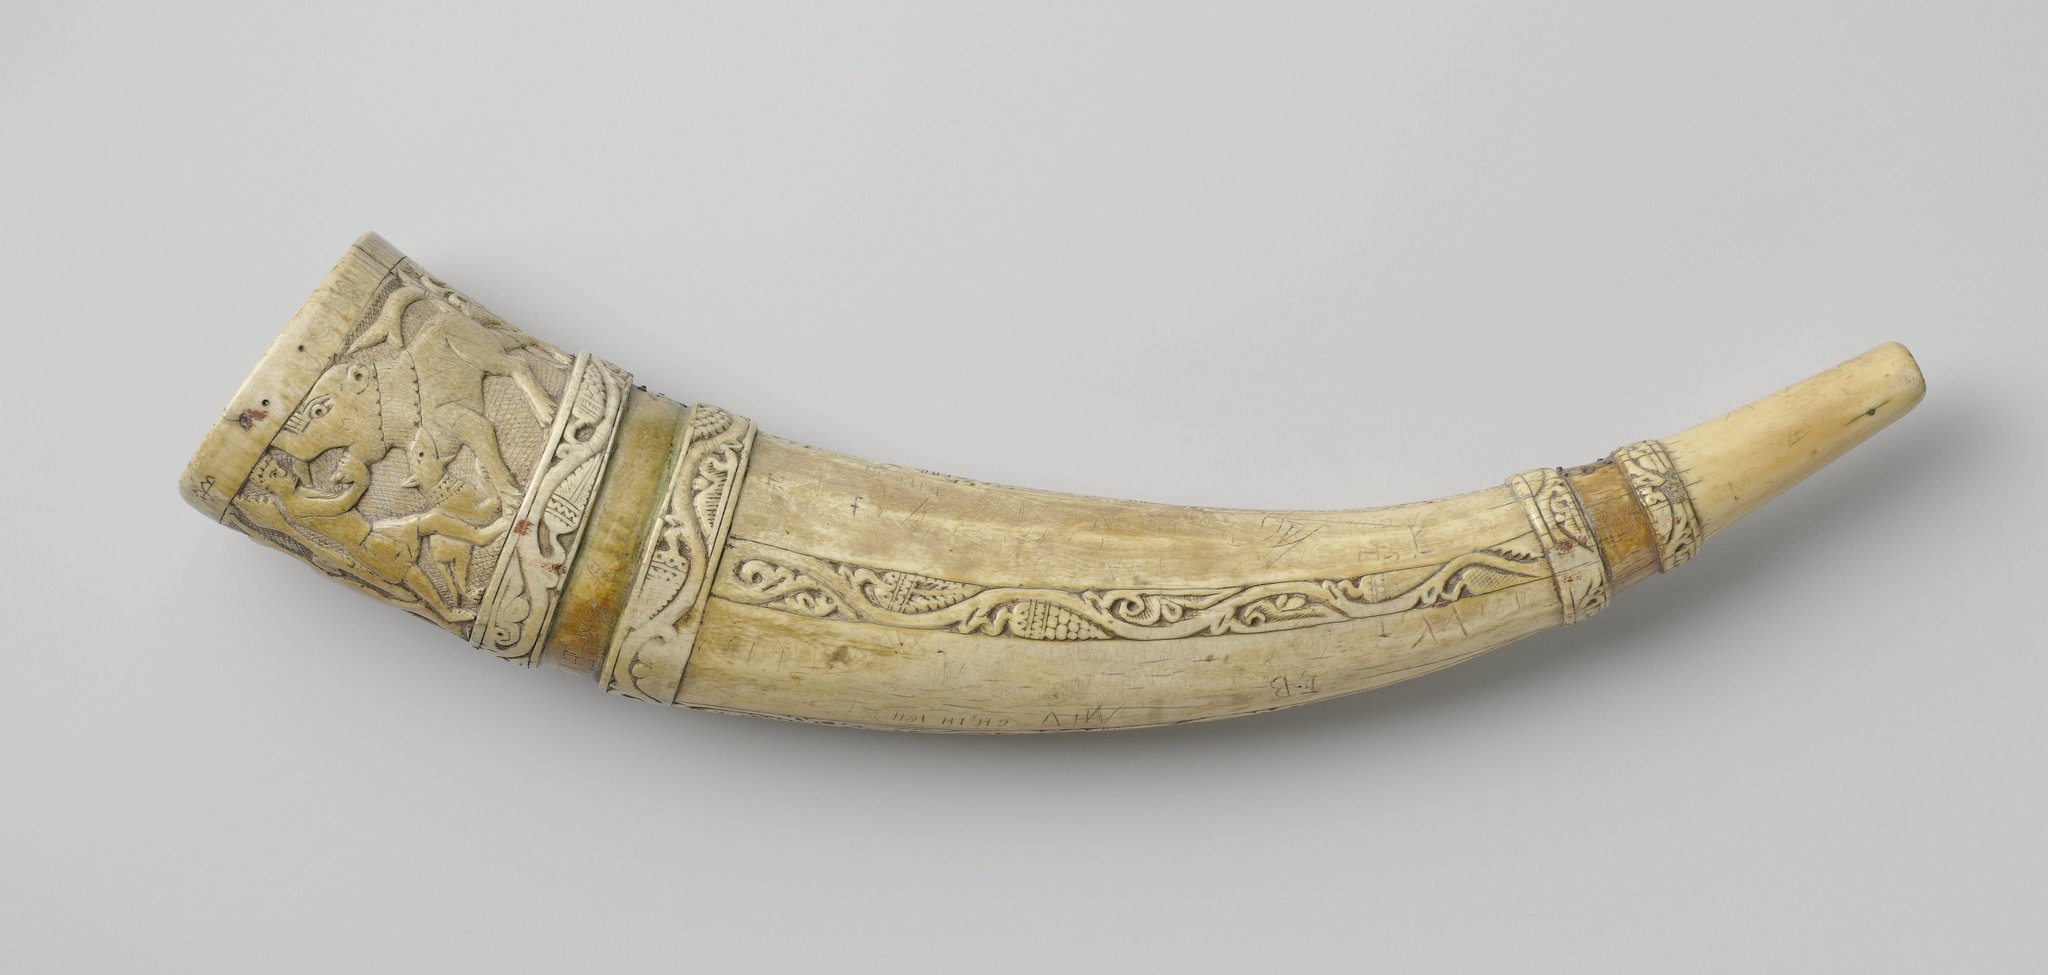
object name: wind instrument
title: Hunting horn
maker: Anonymous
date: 1000-1099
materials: ivory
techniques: cutting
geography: southern italy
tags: fabulous animals (sometimes wrongly called 'grotesques'); 'mostri' (ripa), hunting, chase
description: This horn once hung with a similar one (now lost) in the middle of the Mariakerk, Utrecht. Both were given to the Bishop of Utrecht in 1095 but came from the abbey of Saint Hubert (patron saint of hunters) in the Belgian Ardennes. The horn is decorated with hunting scenes; around the wide end are two hunters attacking wild animals.